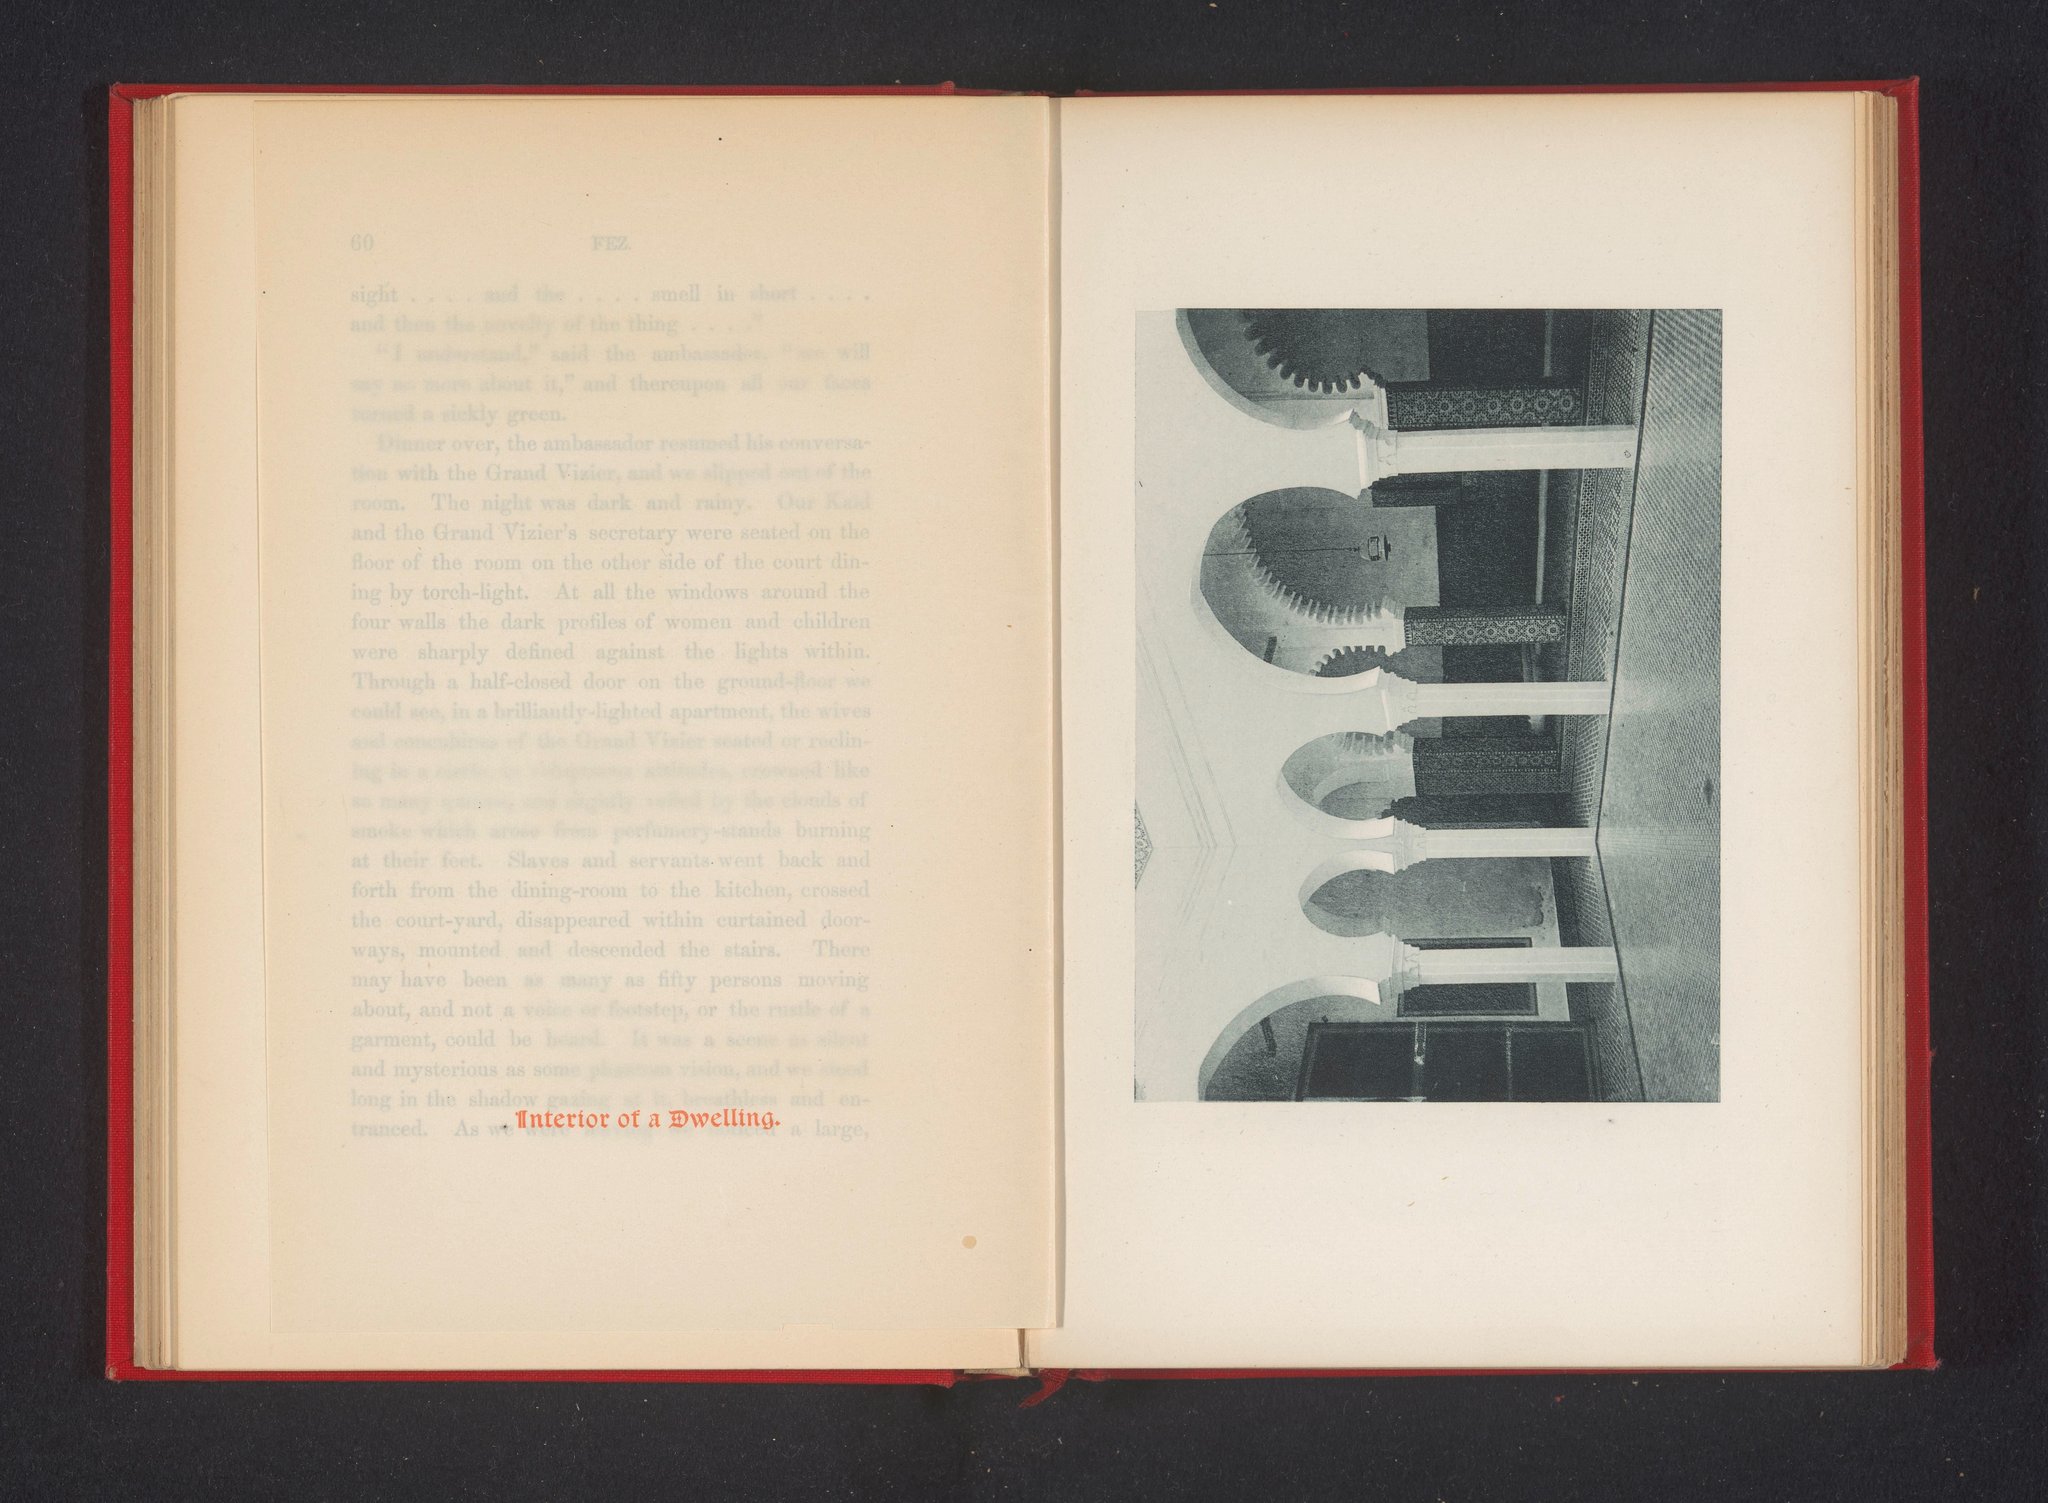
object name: photomechanical print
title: Binnenplaats van een woning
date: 1887-1897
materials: paper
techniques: photoaquatint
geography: morocco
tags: housing, façade of inner court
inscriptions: title: ‘Interior of a Dwelling’